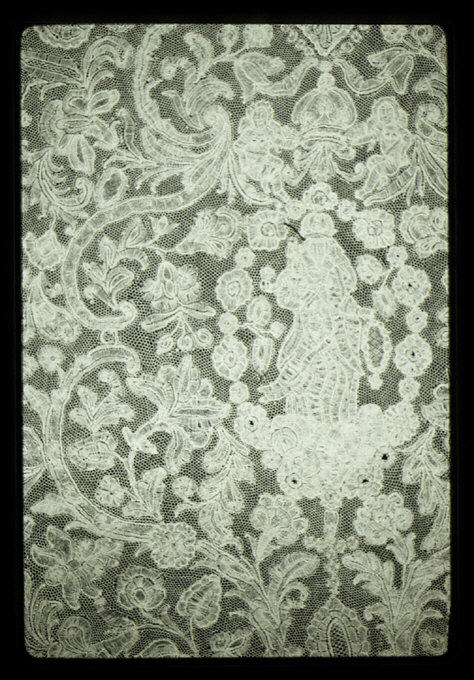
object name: piece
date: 1667-1700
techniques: lace